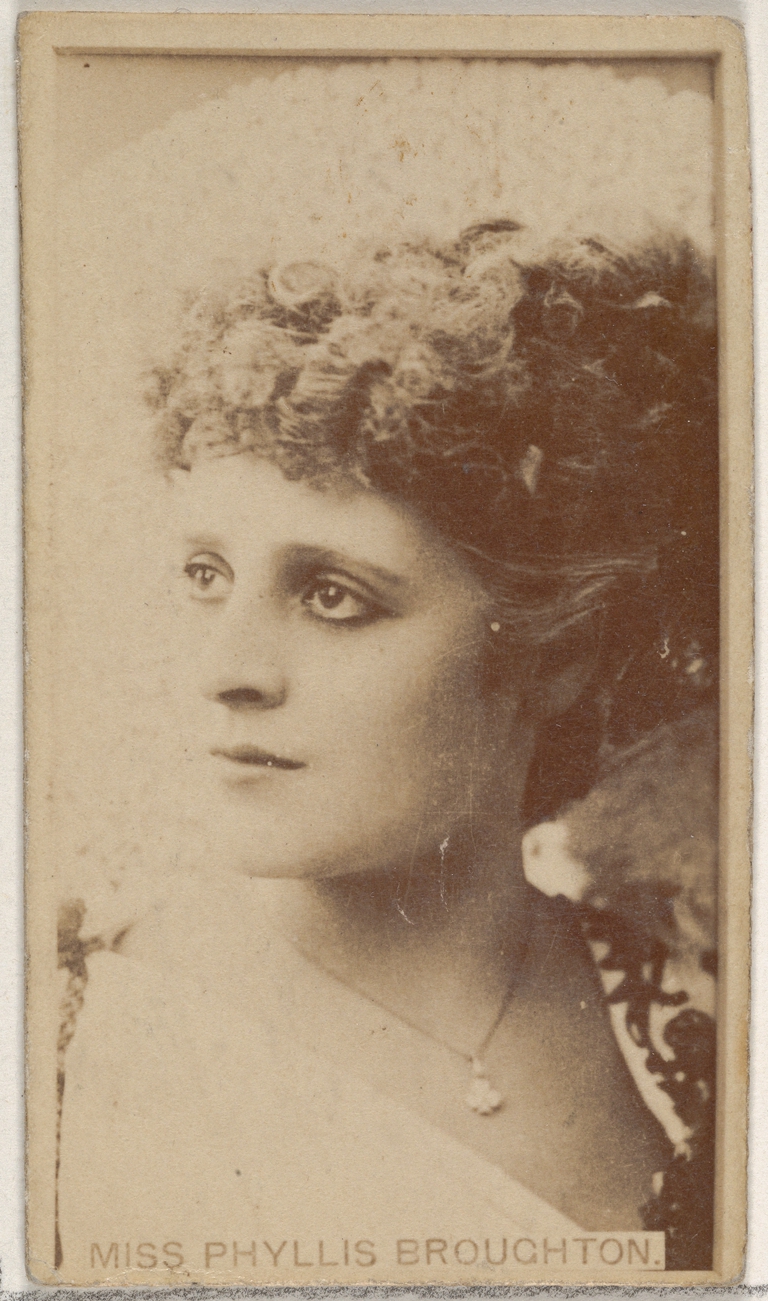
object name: photograph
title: Miss Phyllis Broughton, from the Actors and Actresses series (N45, Type 8) for Virginia Brights Cigarettes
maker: allen & ginter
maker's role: publisher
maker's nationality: american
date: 1888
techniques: albumen silver print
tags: portraits,women,actresses